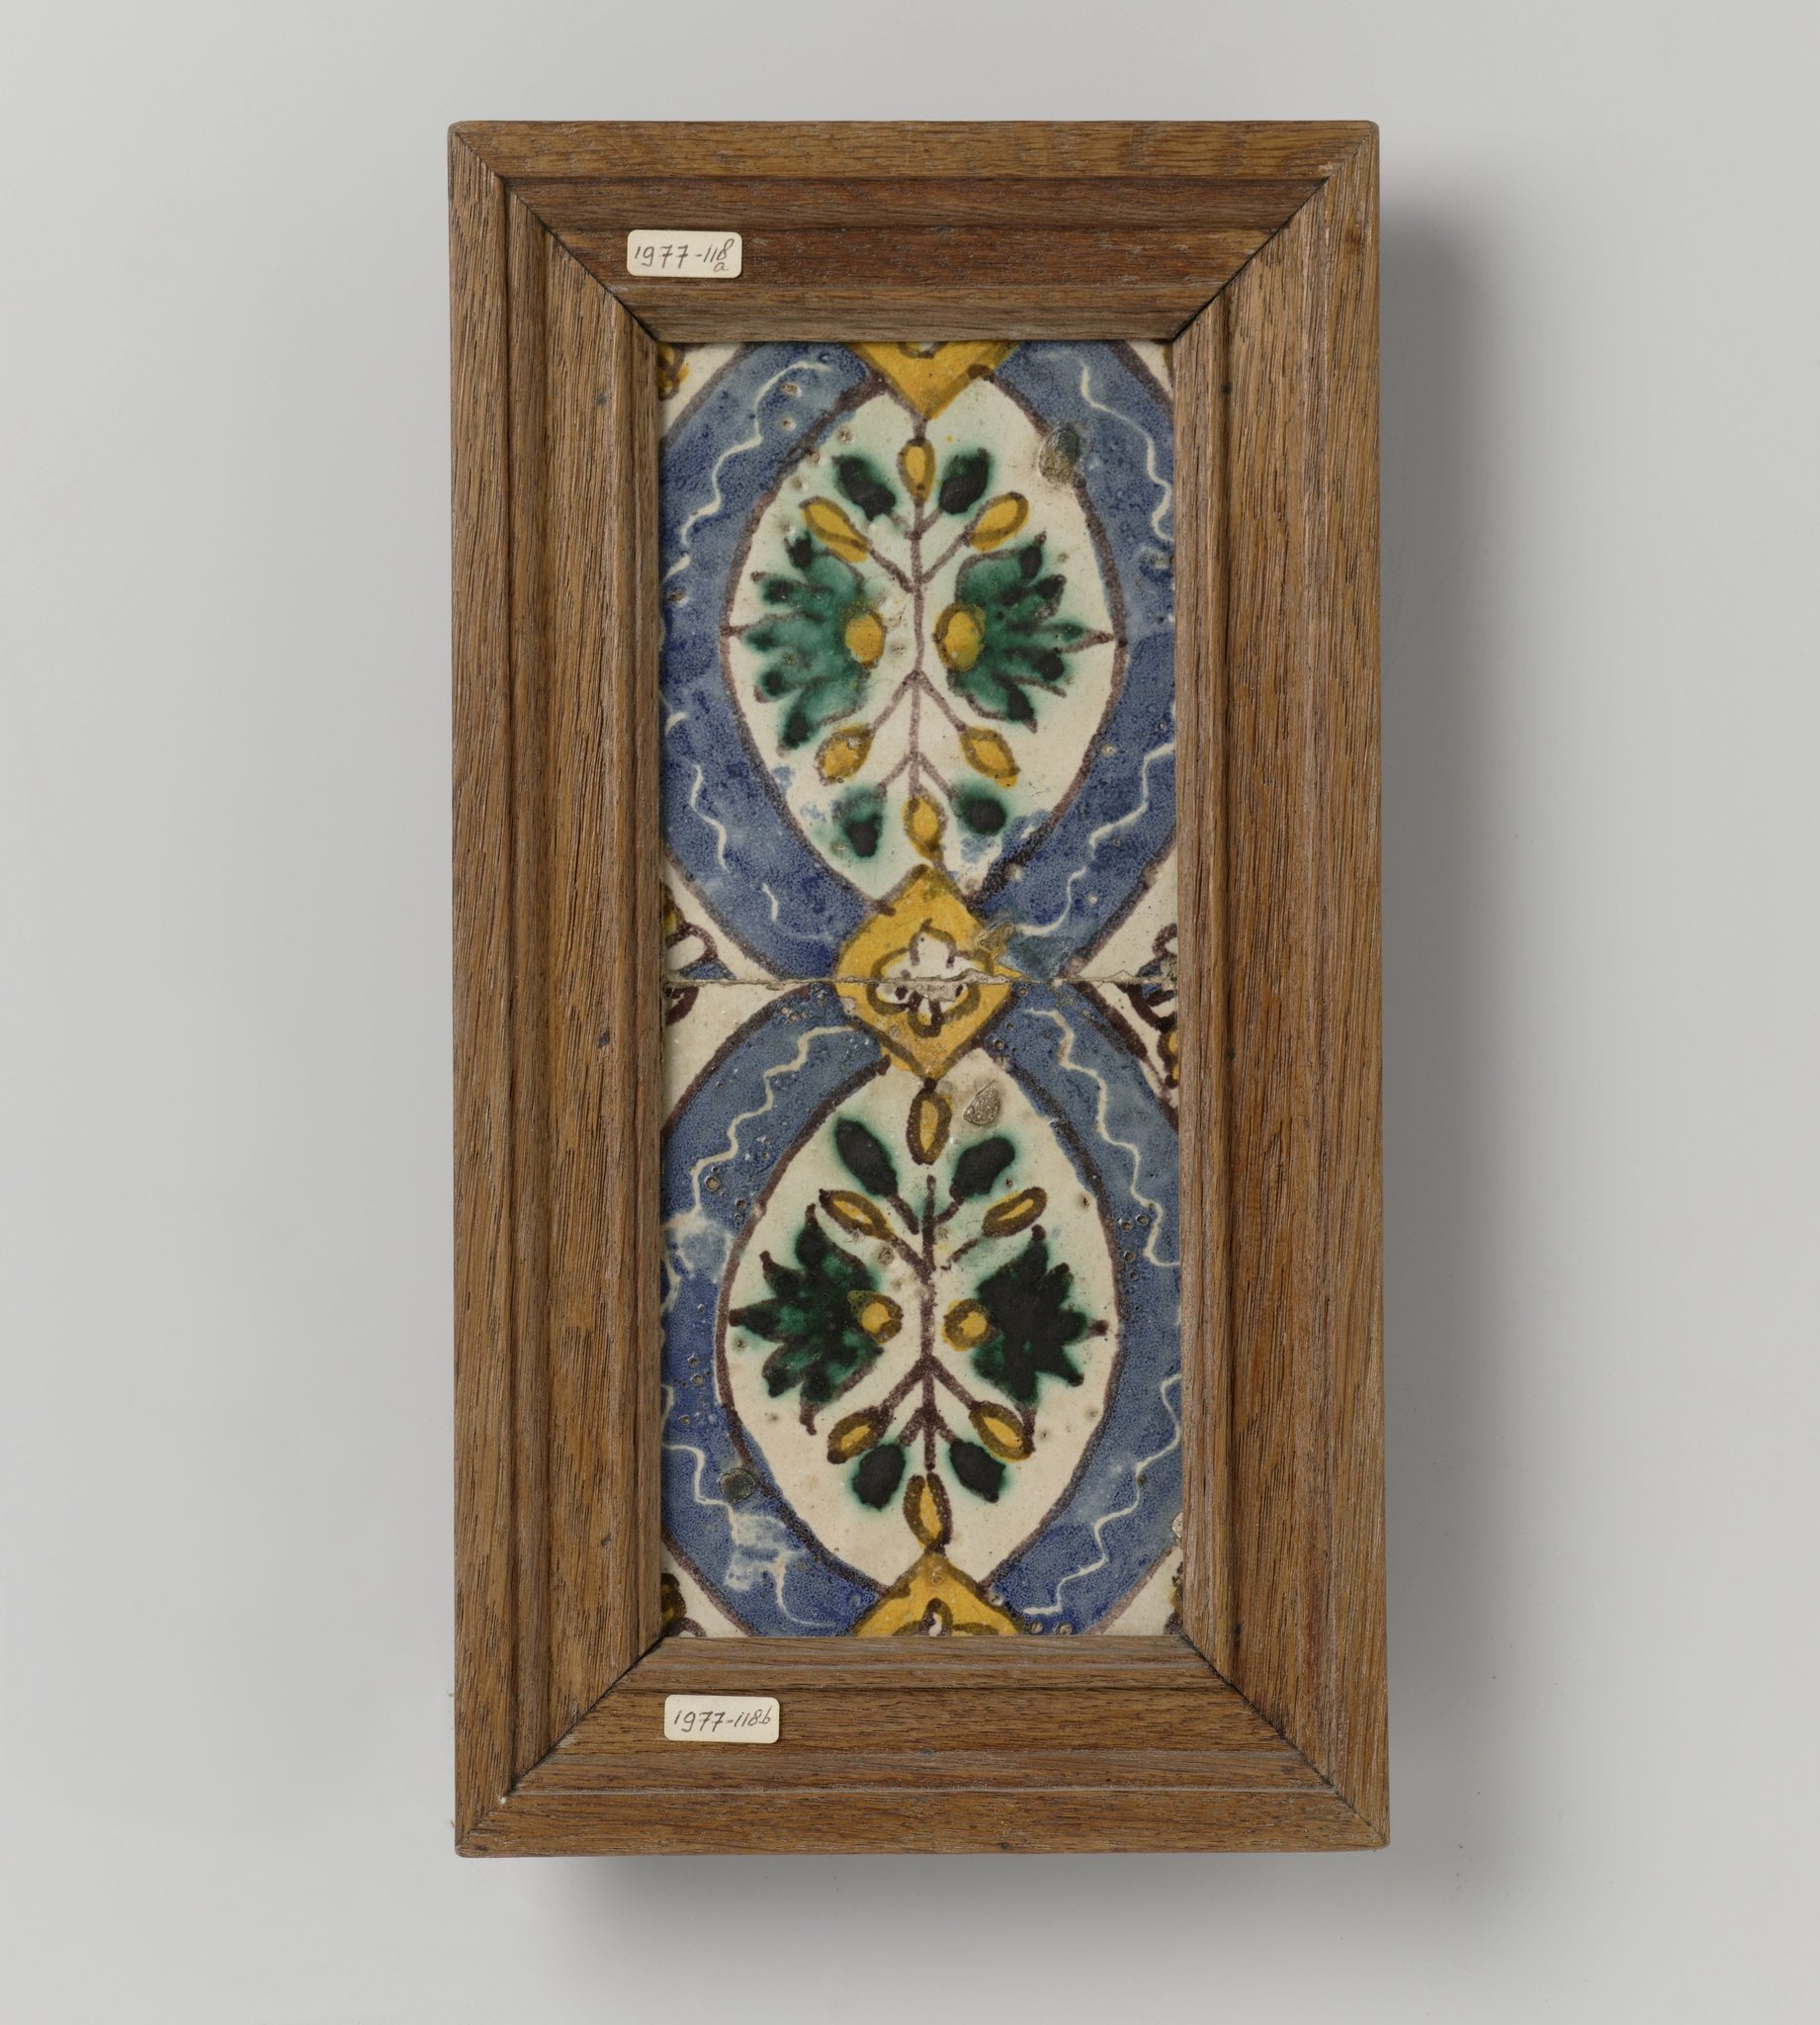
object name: tile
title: Tegel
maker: Anonymous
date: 1700-1800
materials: earthenware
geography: spain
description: Tegel van aardewerk, beschilderd in blauw, groen, geel en mangaan, blauw ovaal waarbinnen symmetrisch bladmotief. In de hoeken delen van rozetten. Met BK-1977-118-a in moderne houten lijst.